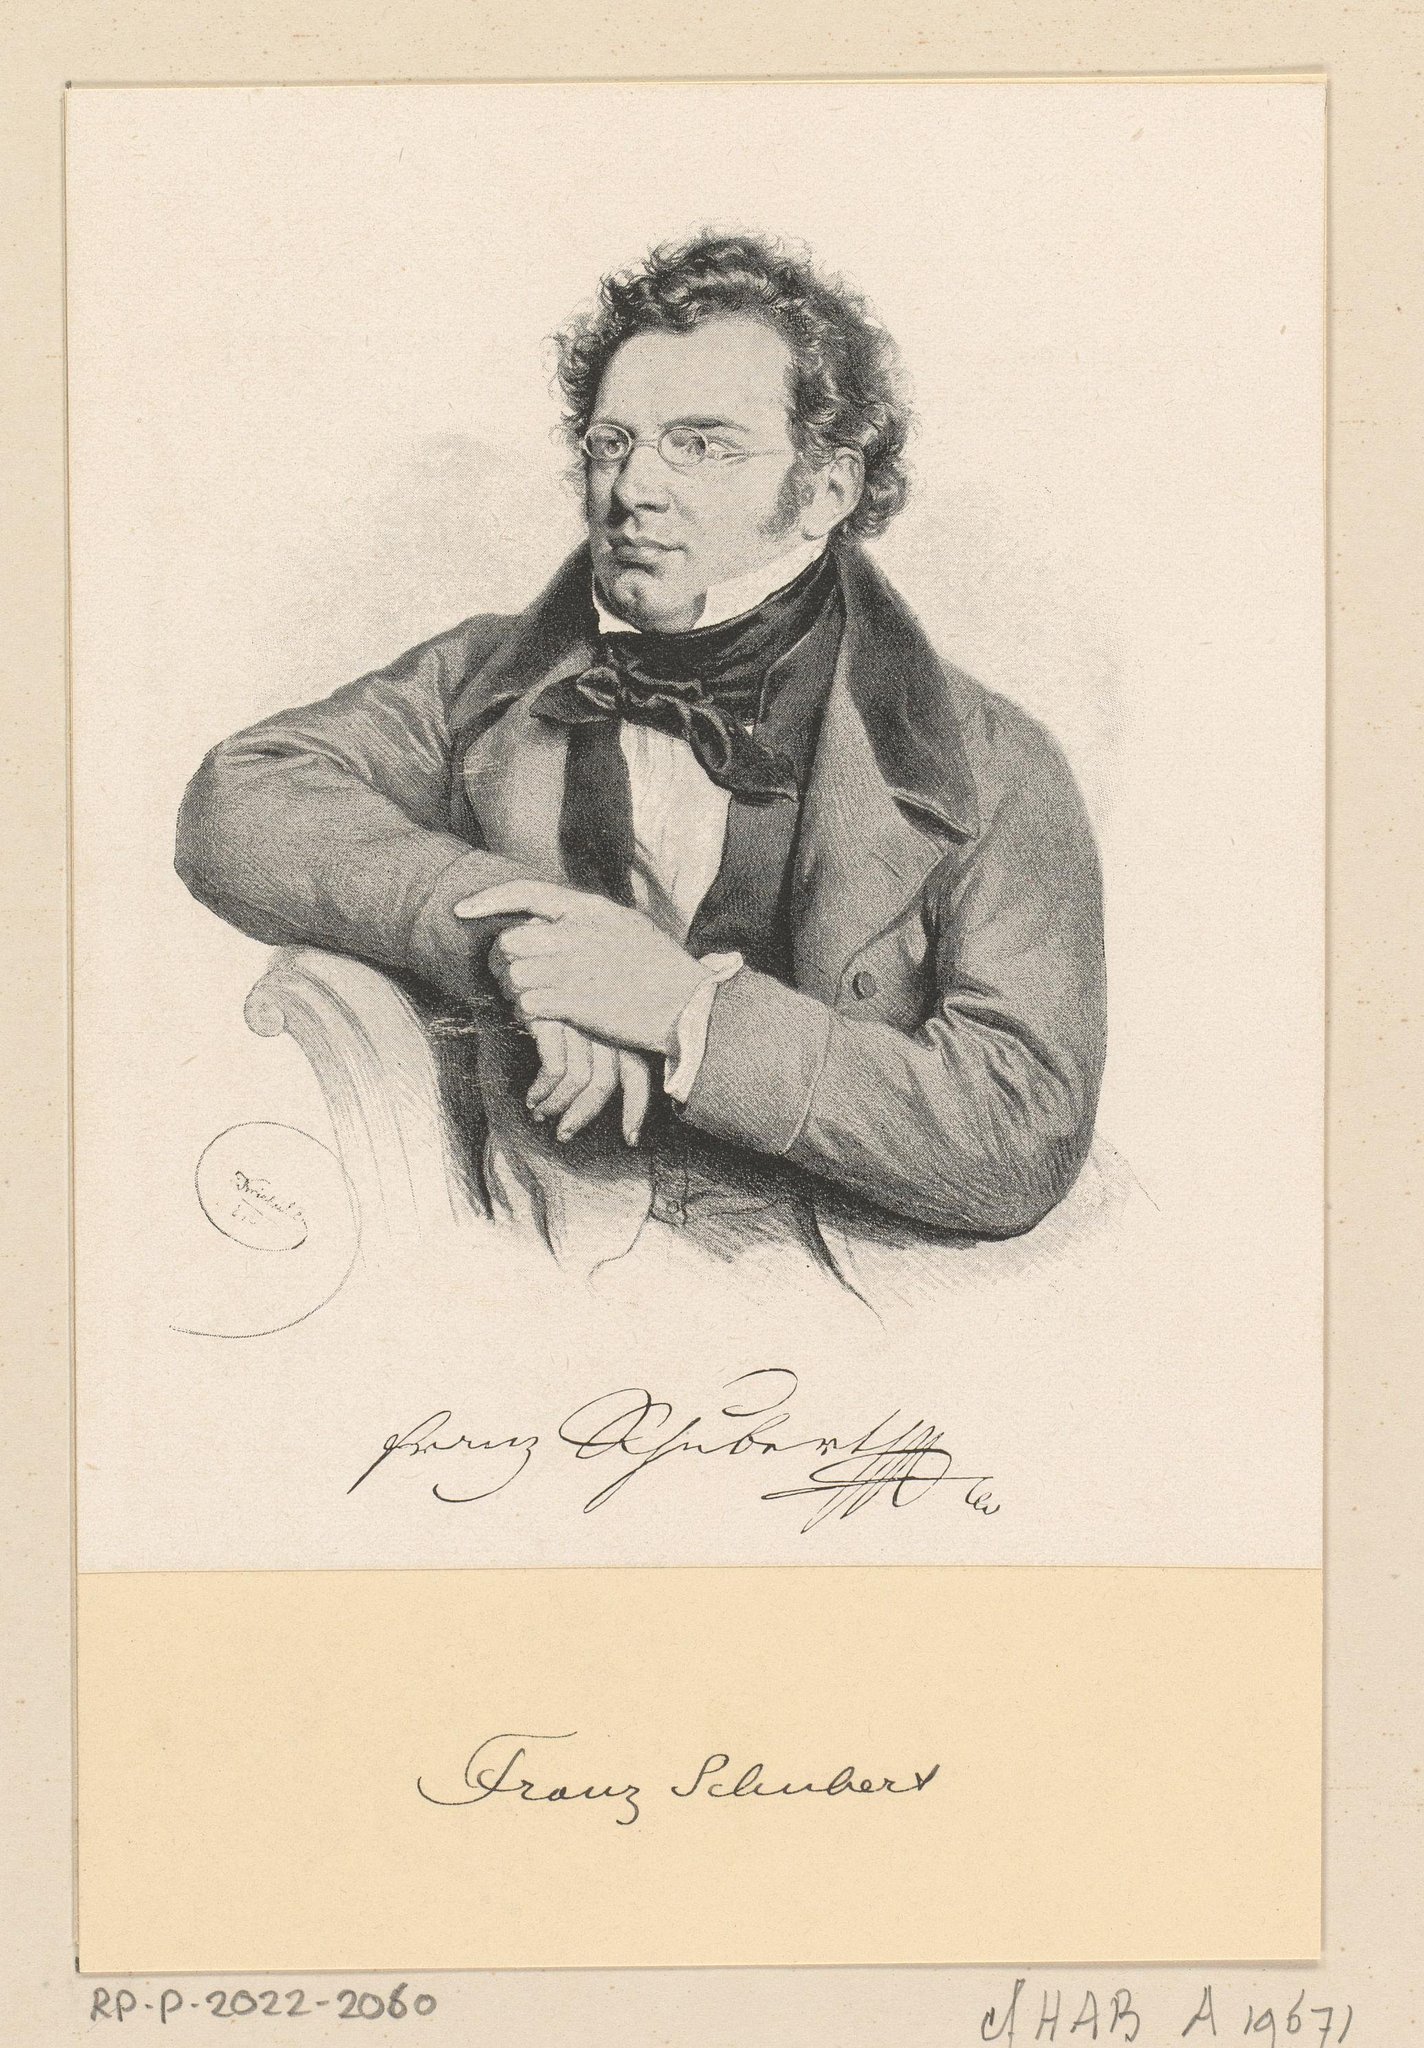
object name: photomechanical print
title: Portret van Franz Schubert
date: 1882-1970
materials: paper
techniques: snipping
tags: vienna, franz schubert, historical persons, portrait of composer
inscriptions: name: ‘Franz Schubert’